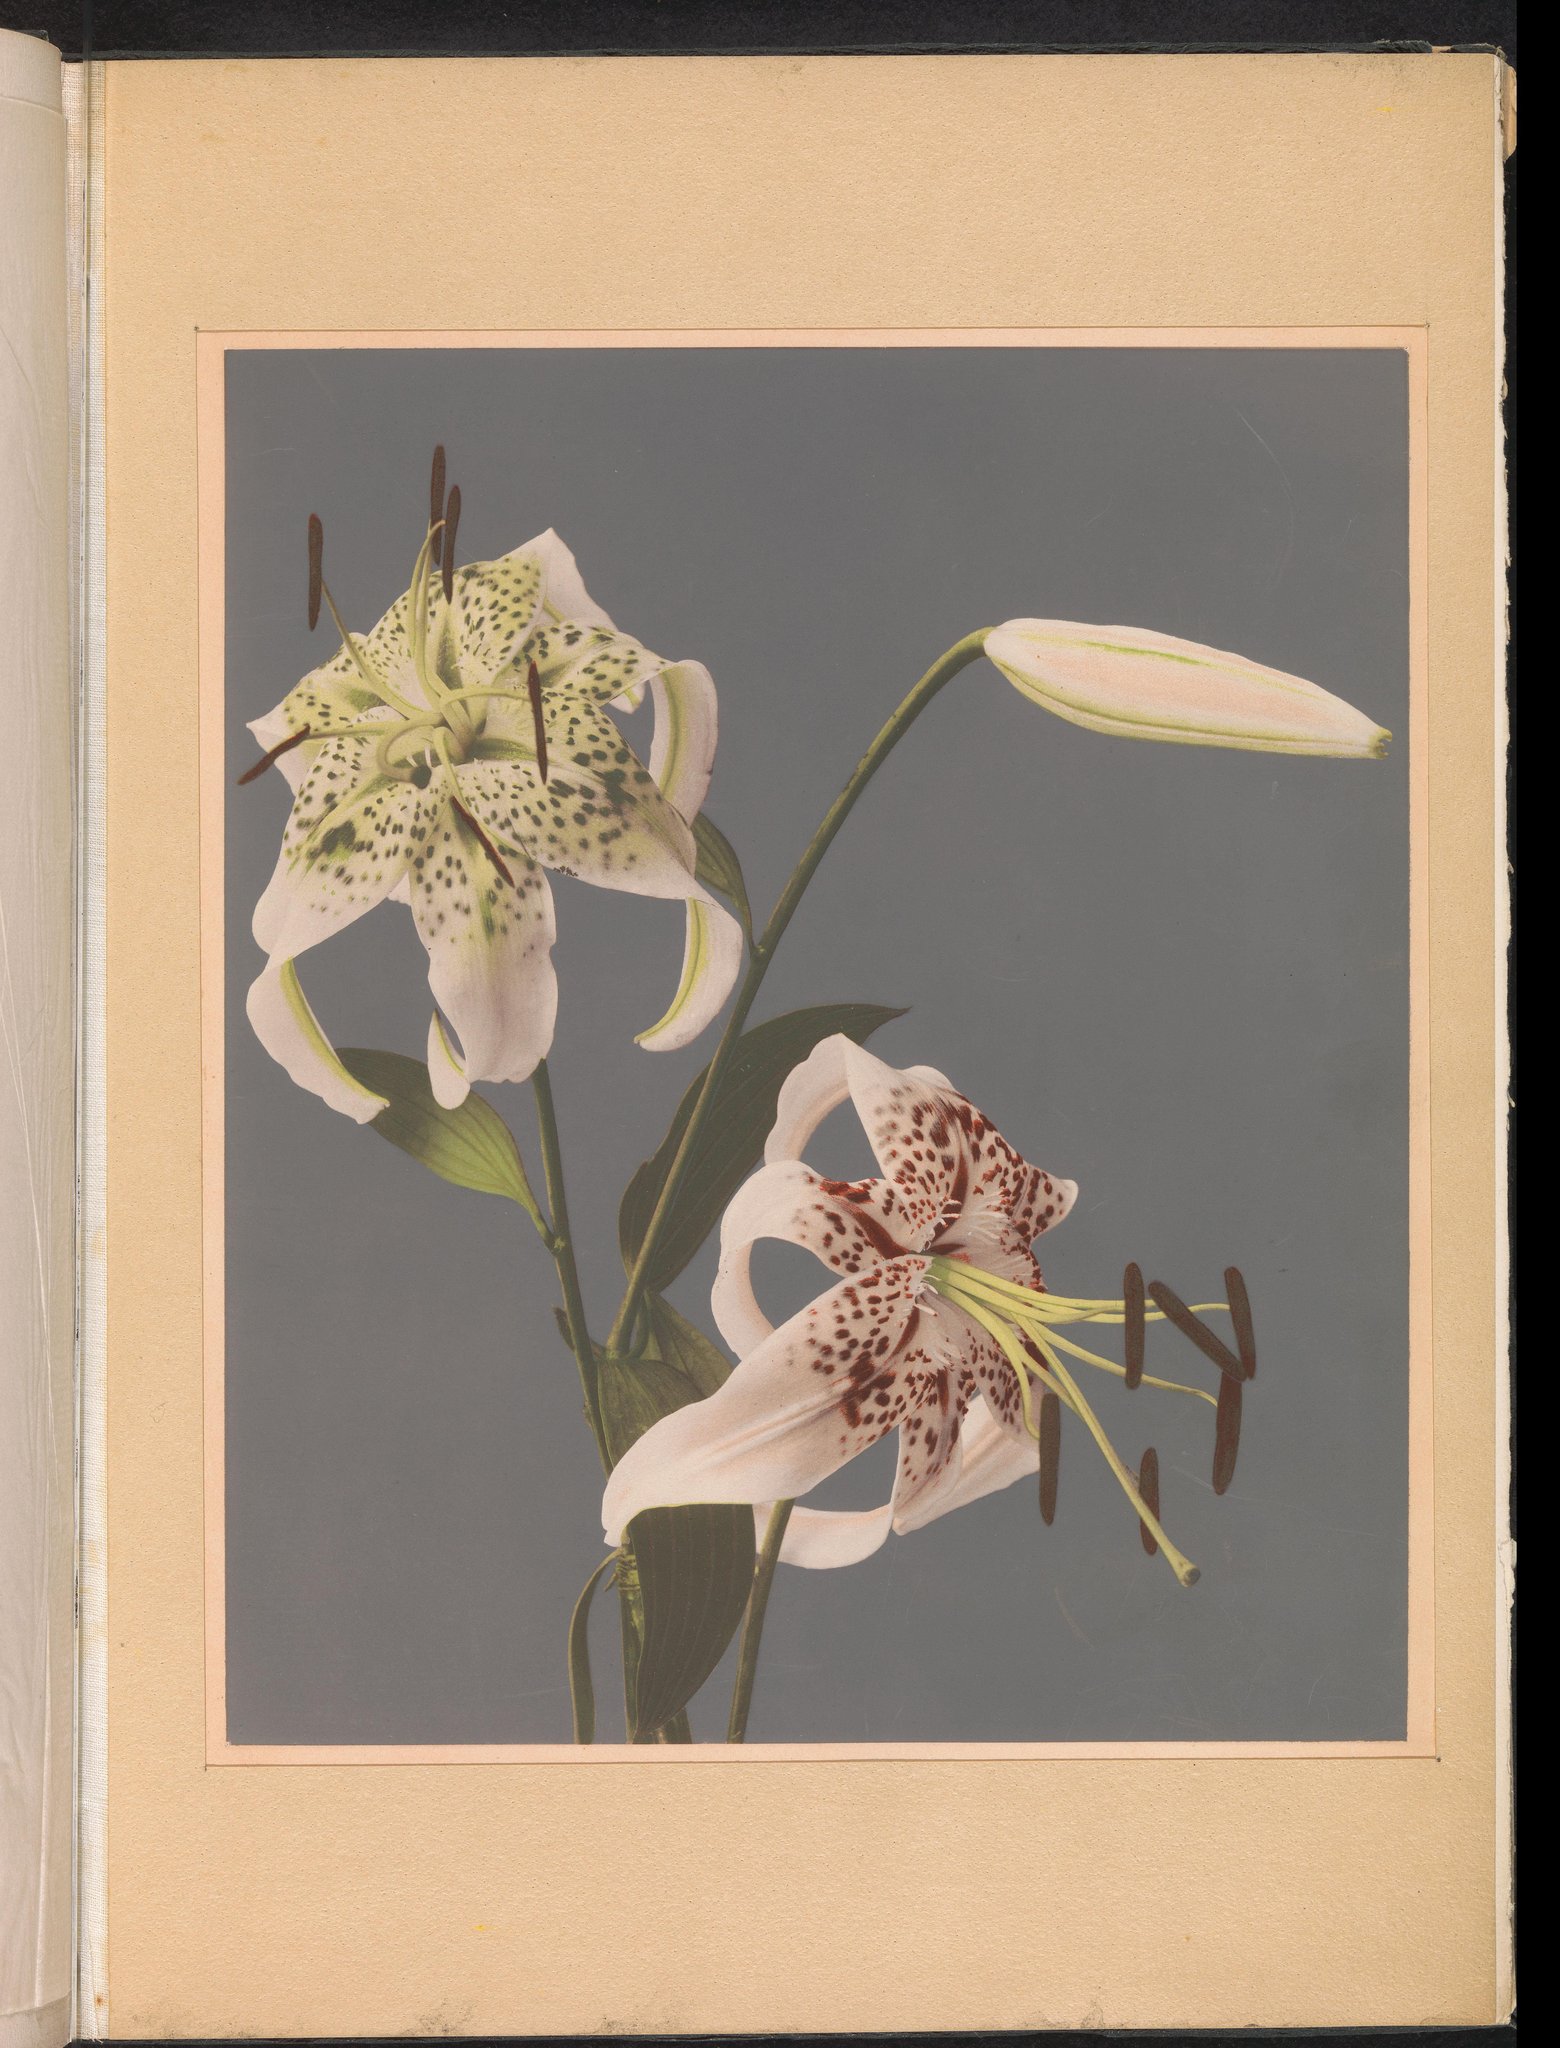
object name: page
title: Twee Japanse lelies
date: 1887-1897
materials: paper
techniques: photograph, hand coloring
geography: japan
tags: flowers: lily